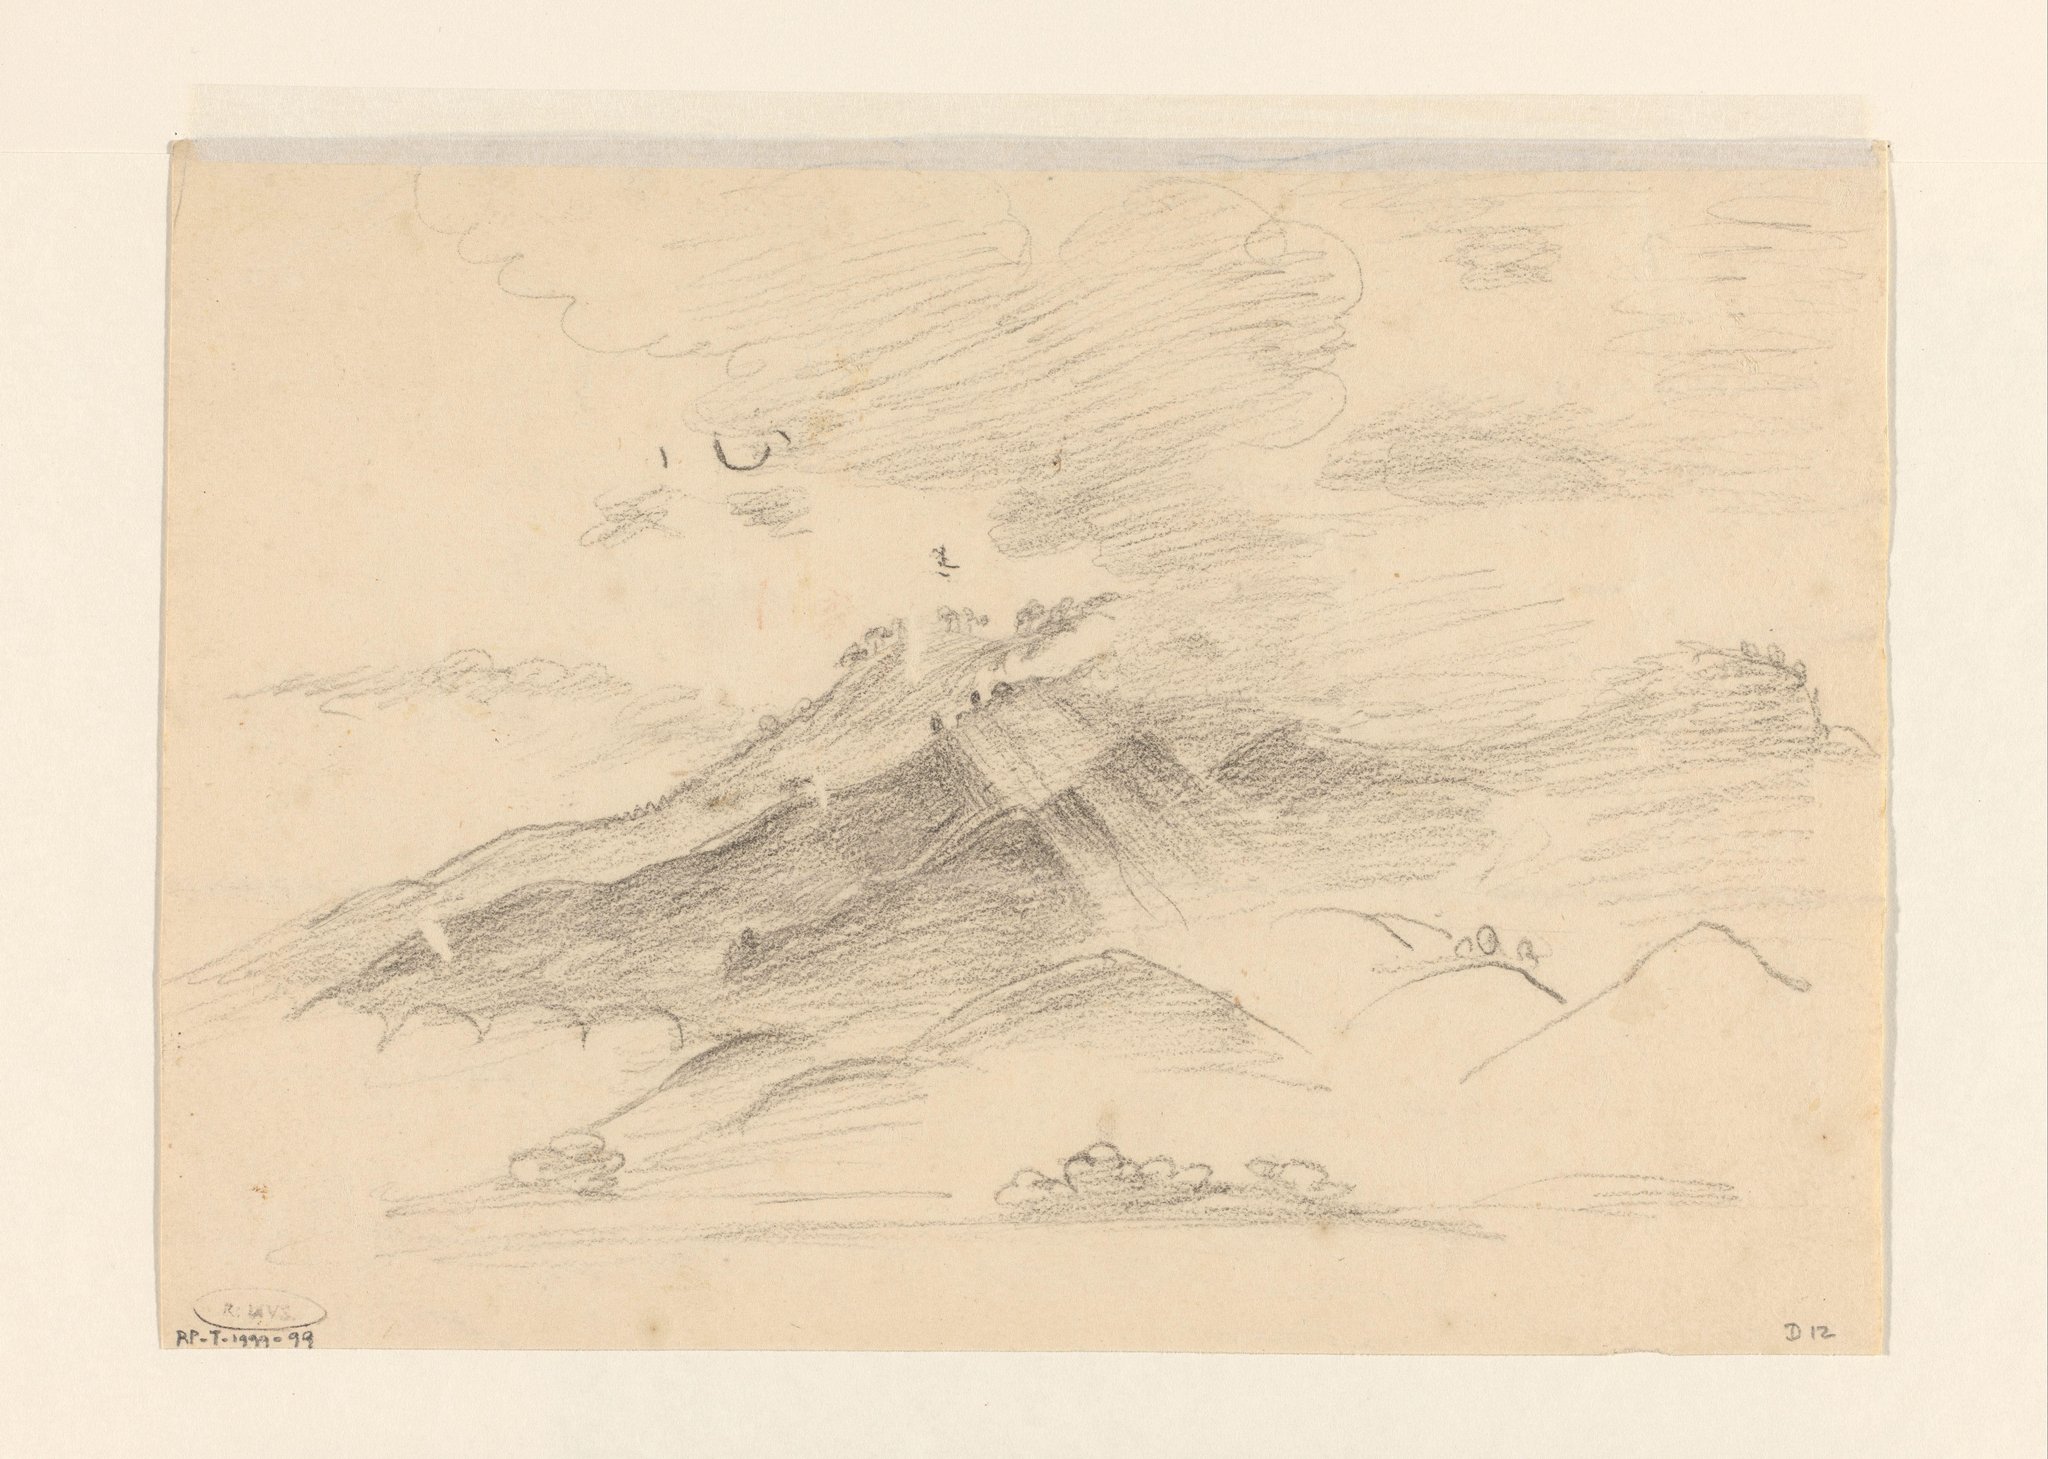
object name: drawing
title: Berglandschap op West-Java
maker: adrianus johannes bik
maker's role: draughtsman, print maker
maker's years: 1790-1872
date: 1816-1846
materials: chalk, paper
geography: west java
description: artikel over deze collectie in Bulletin van het Rijksmuseum 49 [2001], nr. 4, pp 342 e.v.